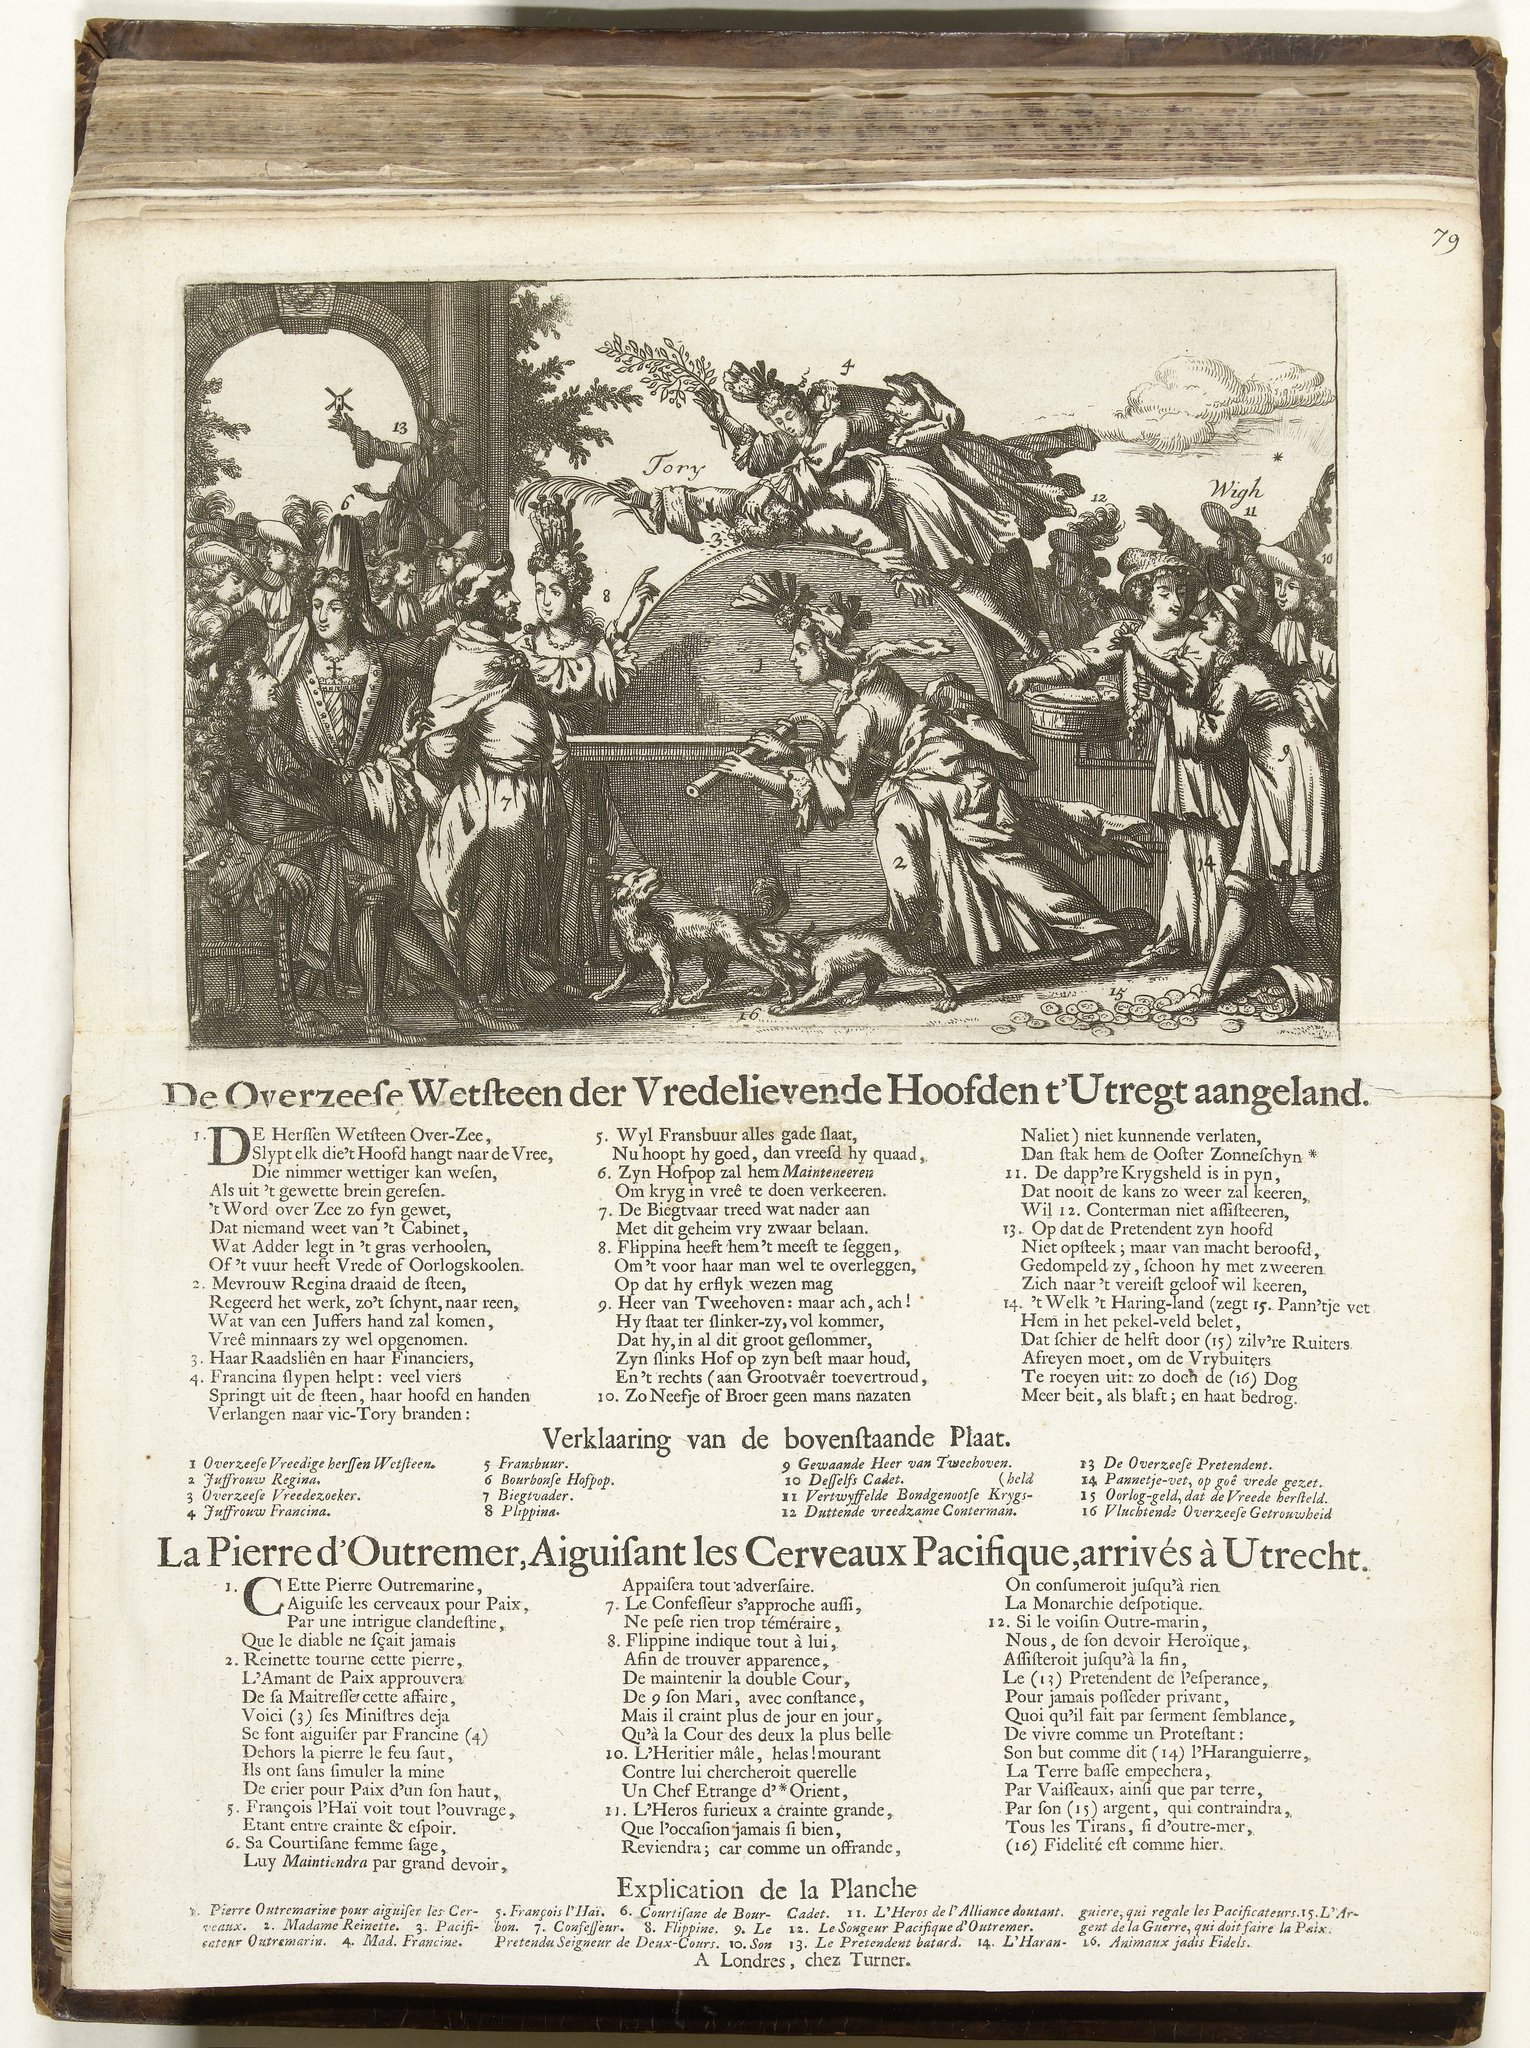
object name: print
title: De Overzeese Wetsteen der Vredelievende Hoofden t'Utregt aangeland / La Pierre d'Outremer, Aiguisant les Cerveaux Pacifique, arrivés à Utrecht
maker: abraham allard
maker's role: print maker, publisher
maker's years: 1676-1725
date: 1713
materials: paper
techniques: etching, letterpress printing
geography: amsterdam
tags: sharpening, grinding (industrial processes), political caricatures and satires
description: Spotprent op de Vrede van Utrecht, 1713. Op een grote slijpsteen aangedreven door koningin Anna wordt het hoofd van een Tory geslepen, links kijkt het Franse hof toe. Op het blad onder de plaat verzen en uitleg in het Nederlands en Frans. Onderdeel van een groep van 28 nieuwe en oude platen aangepast ter illustratie van de Vrede van Utrecht in 1713. Onderdeel van het prentwerk uitgegeven onder de verzameltitel 't Lust-Hof van Momus met de gebundelde series van spotprenten tijdens de jaren 1701-1713 van de Spaanse Successieoorlog.